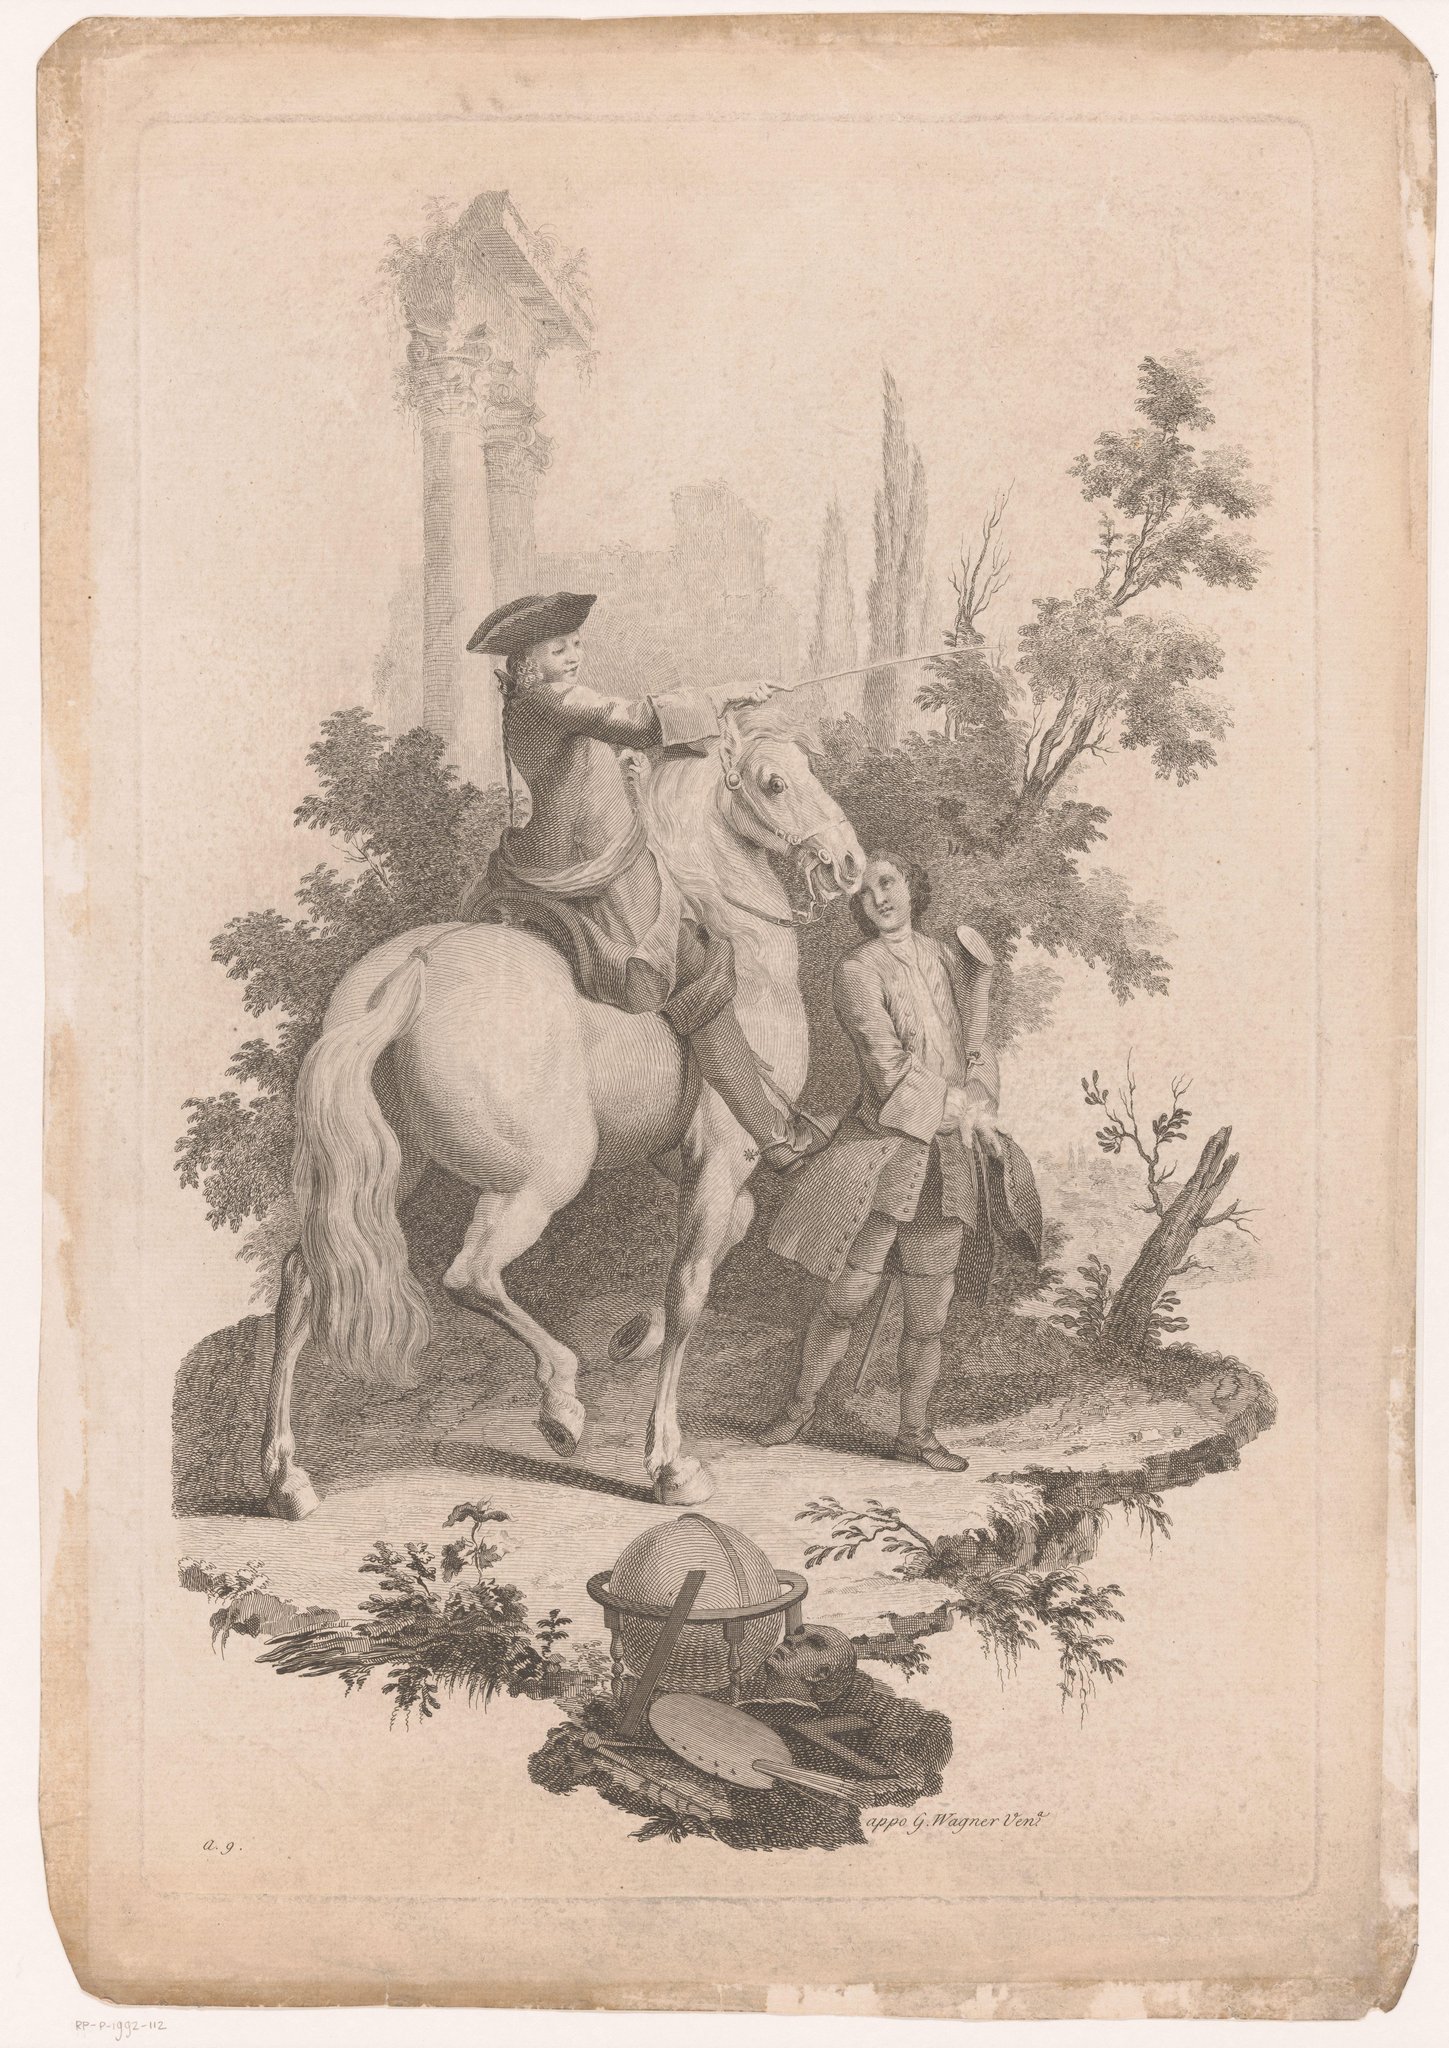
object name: print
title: Jongeman te paard met een bediende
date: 1739-1780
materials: paper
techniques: engraving, etching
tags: riding a horse, ass, or mule; rider, horseman, ruin of a building ~ architecture, measuring-instruments, tools, implements of painter, piece of sculpture, reproduction of a piece of sculpture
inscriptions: collector's mark: Lugt 2228